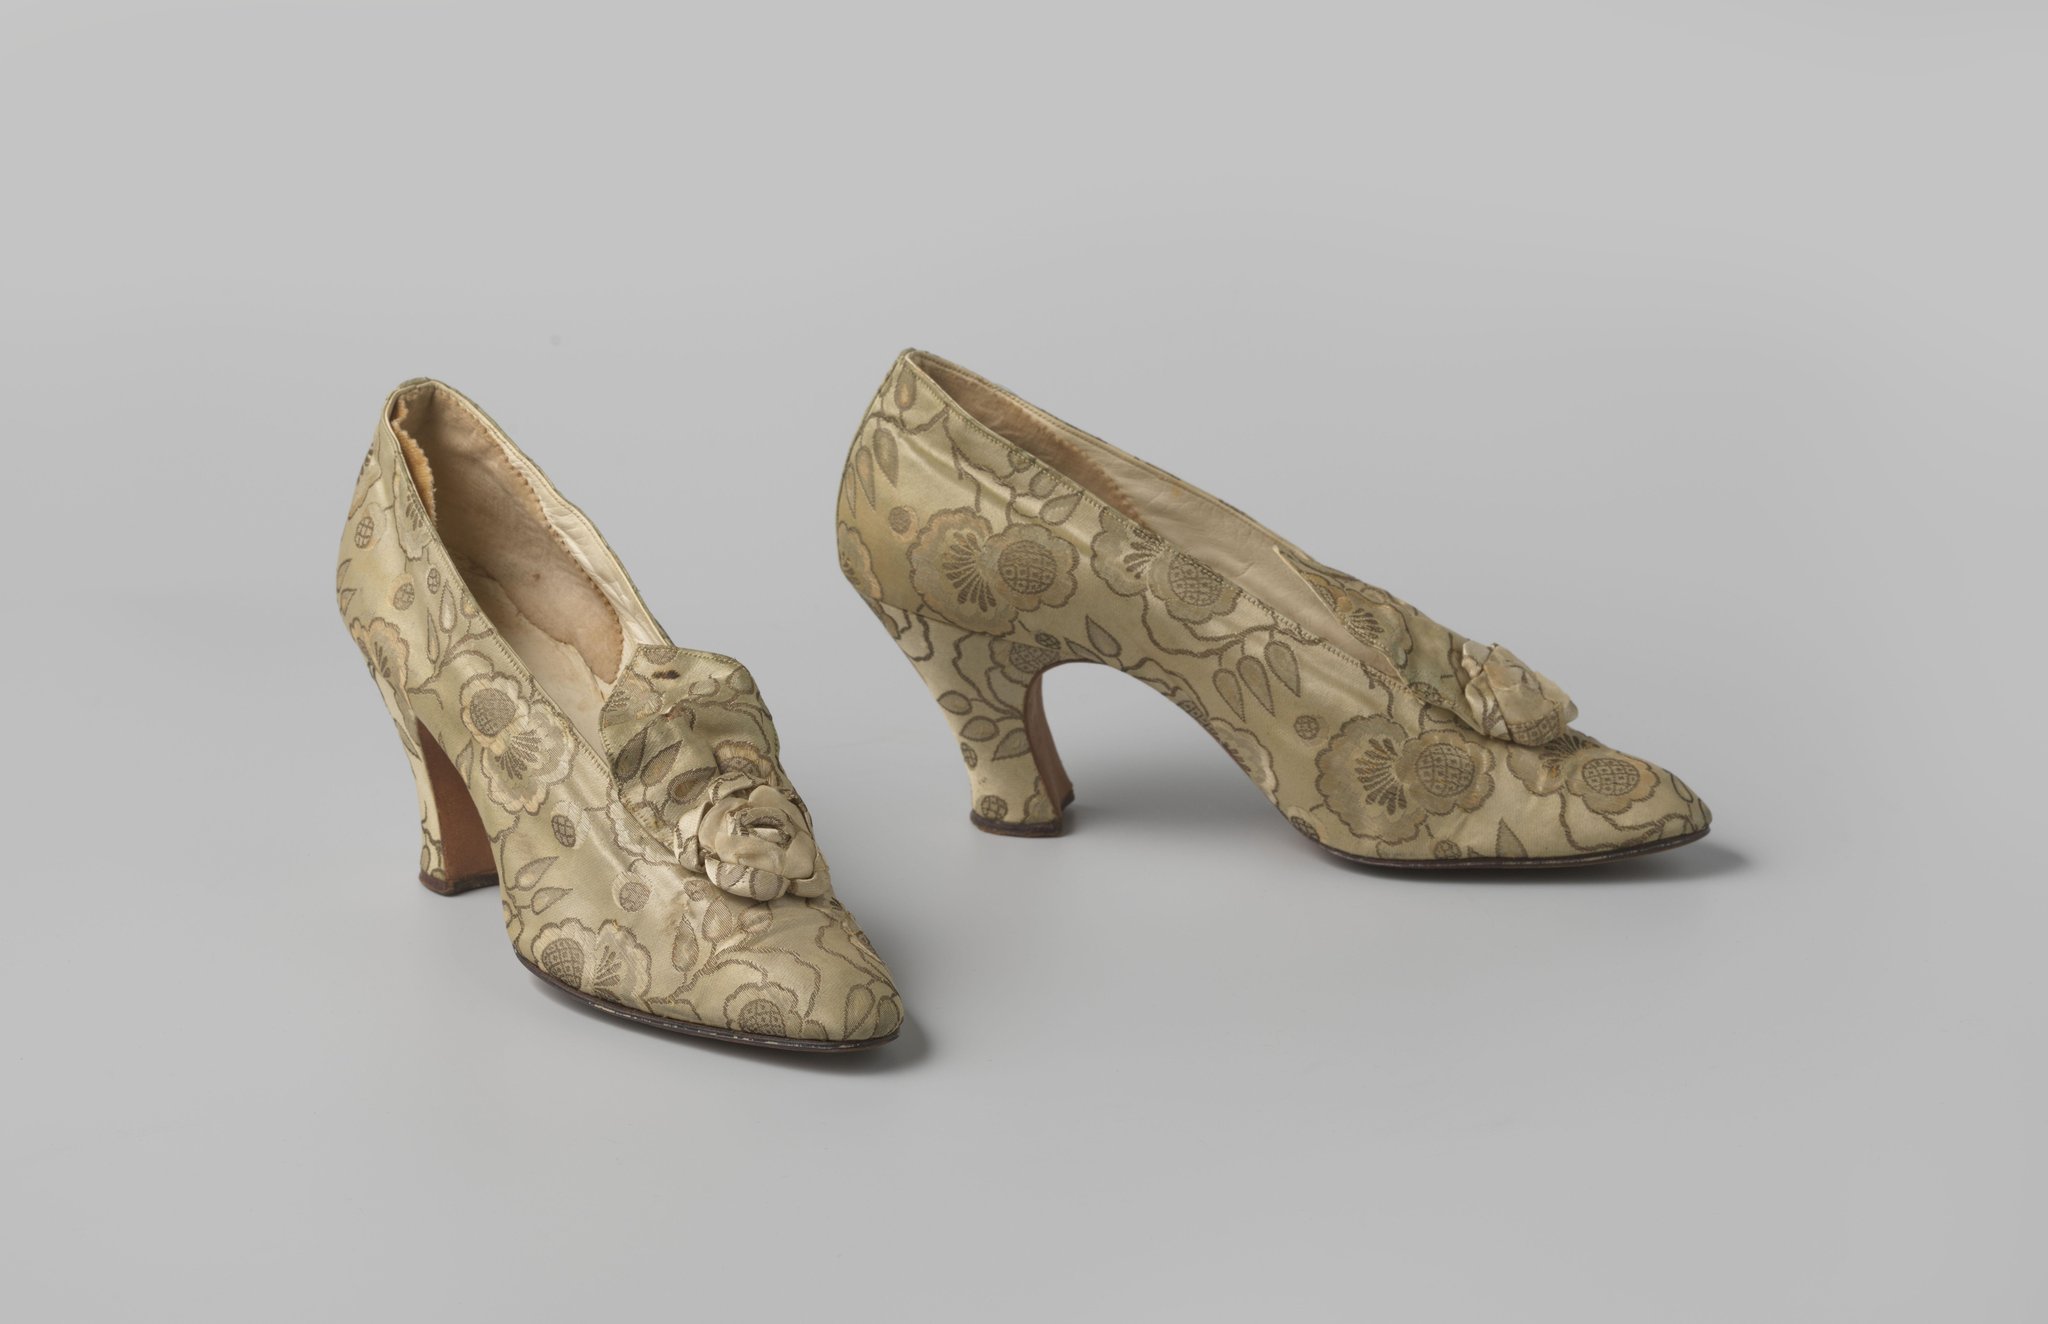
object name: shoe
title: Damesschoen (avondschoen) van crèmekleurige zijden brokaat (rechts)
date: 1930-1940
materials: leather, silk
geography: amsterdam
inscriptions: name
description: Rechterschoen van paar damesschoenen van crèmekleurige zijden brokaat. Model: pump met losse tong waarop een rozet van dito stof, gevoerd met wit kalfsleer. Maat 36/5. In leren zool blindstempel van Hirsch & Cie Amsterdam.